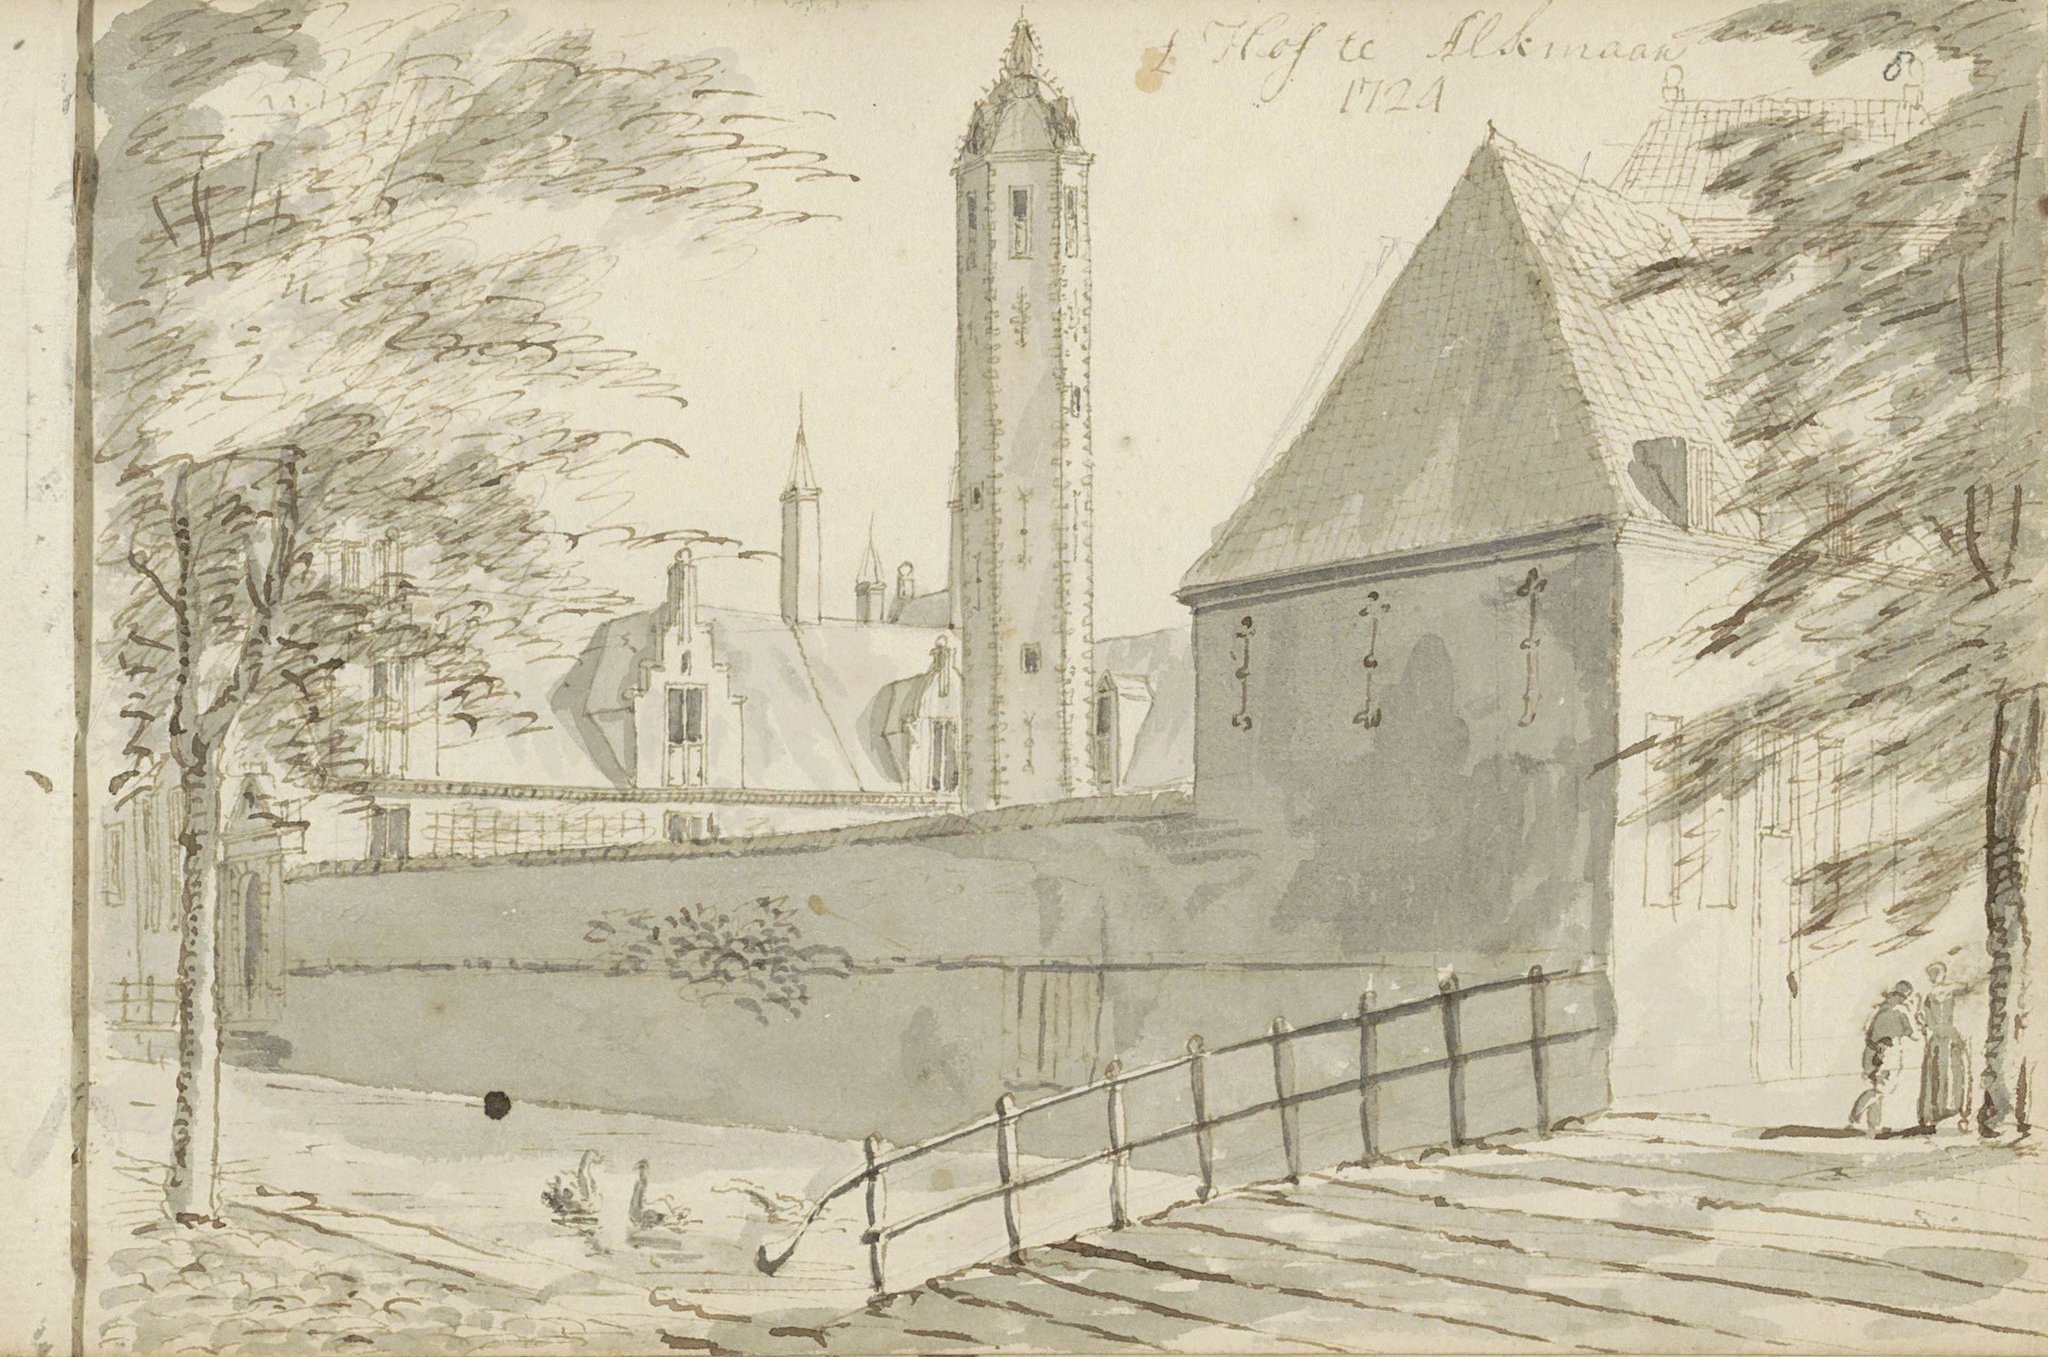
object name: sketchbook leaf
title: Hof van Sonoy te Alkmaar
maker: abraham meyling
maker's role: draughtsman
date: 1724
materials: ink, paper, pencil, watercolor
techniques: brush, pen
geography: alkmaar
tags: urban housing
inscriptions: date and inscription: ‘'t Hof te Alkmaar/ 1724’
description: Hof van Sonoy te Alkmaar met zicht op de achtkantige toren. Boven de buitenmuur zijn daken van gebouwen zichtbaar die deel uitmaken van het Hof. Op de voorgrond een gracht met rechts een brug. Blad 8 recto uit een schetsboek met 21 bladen.